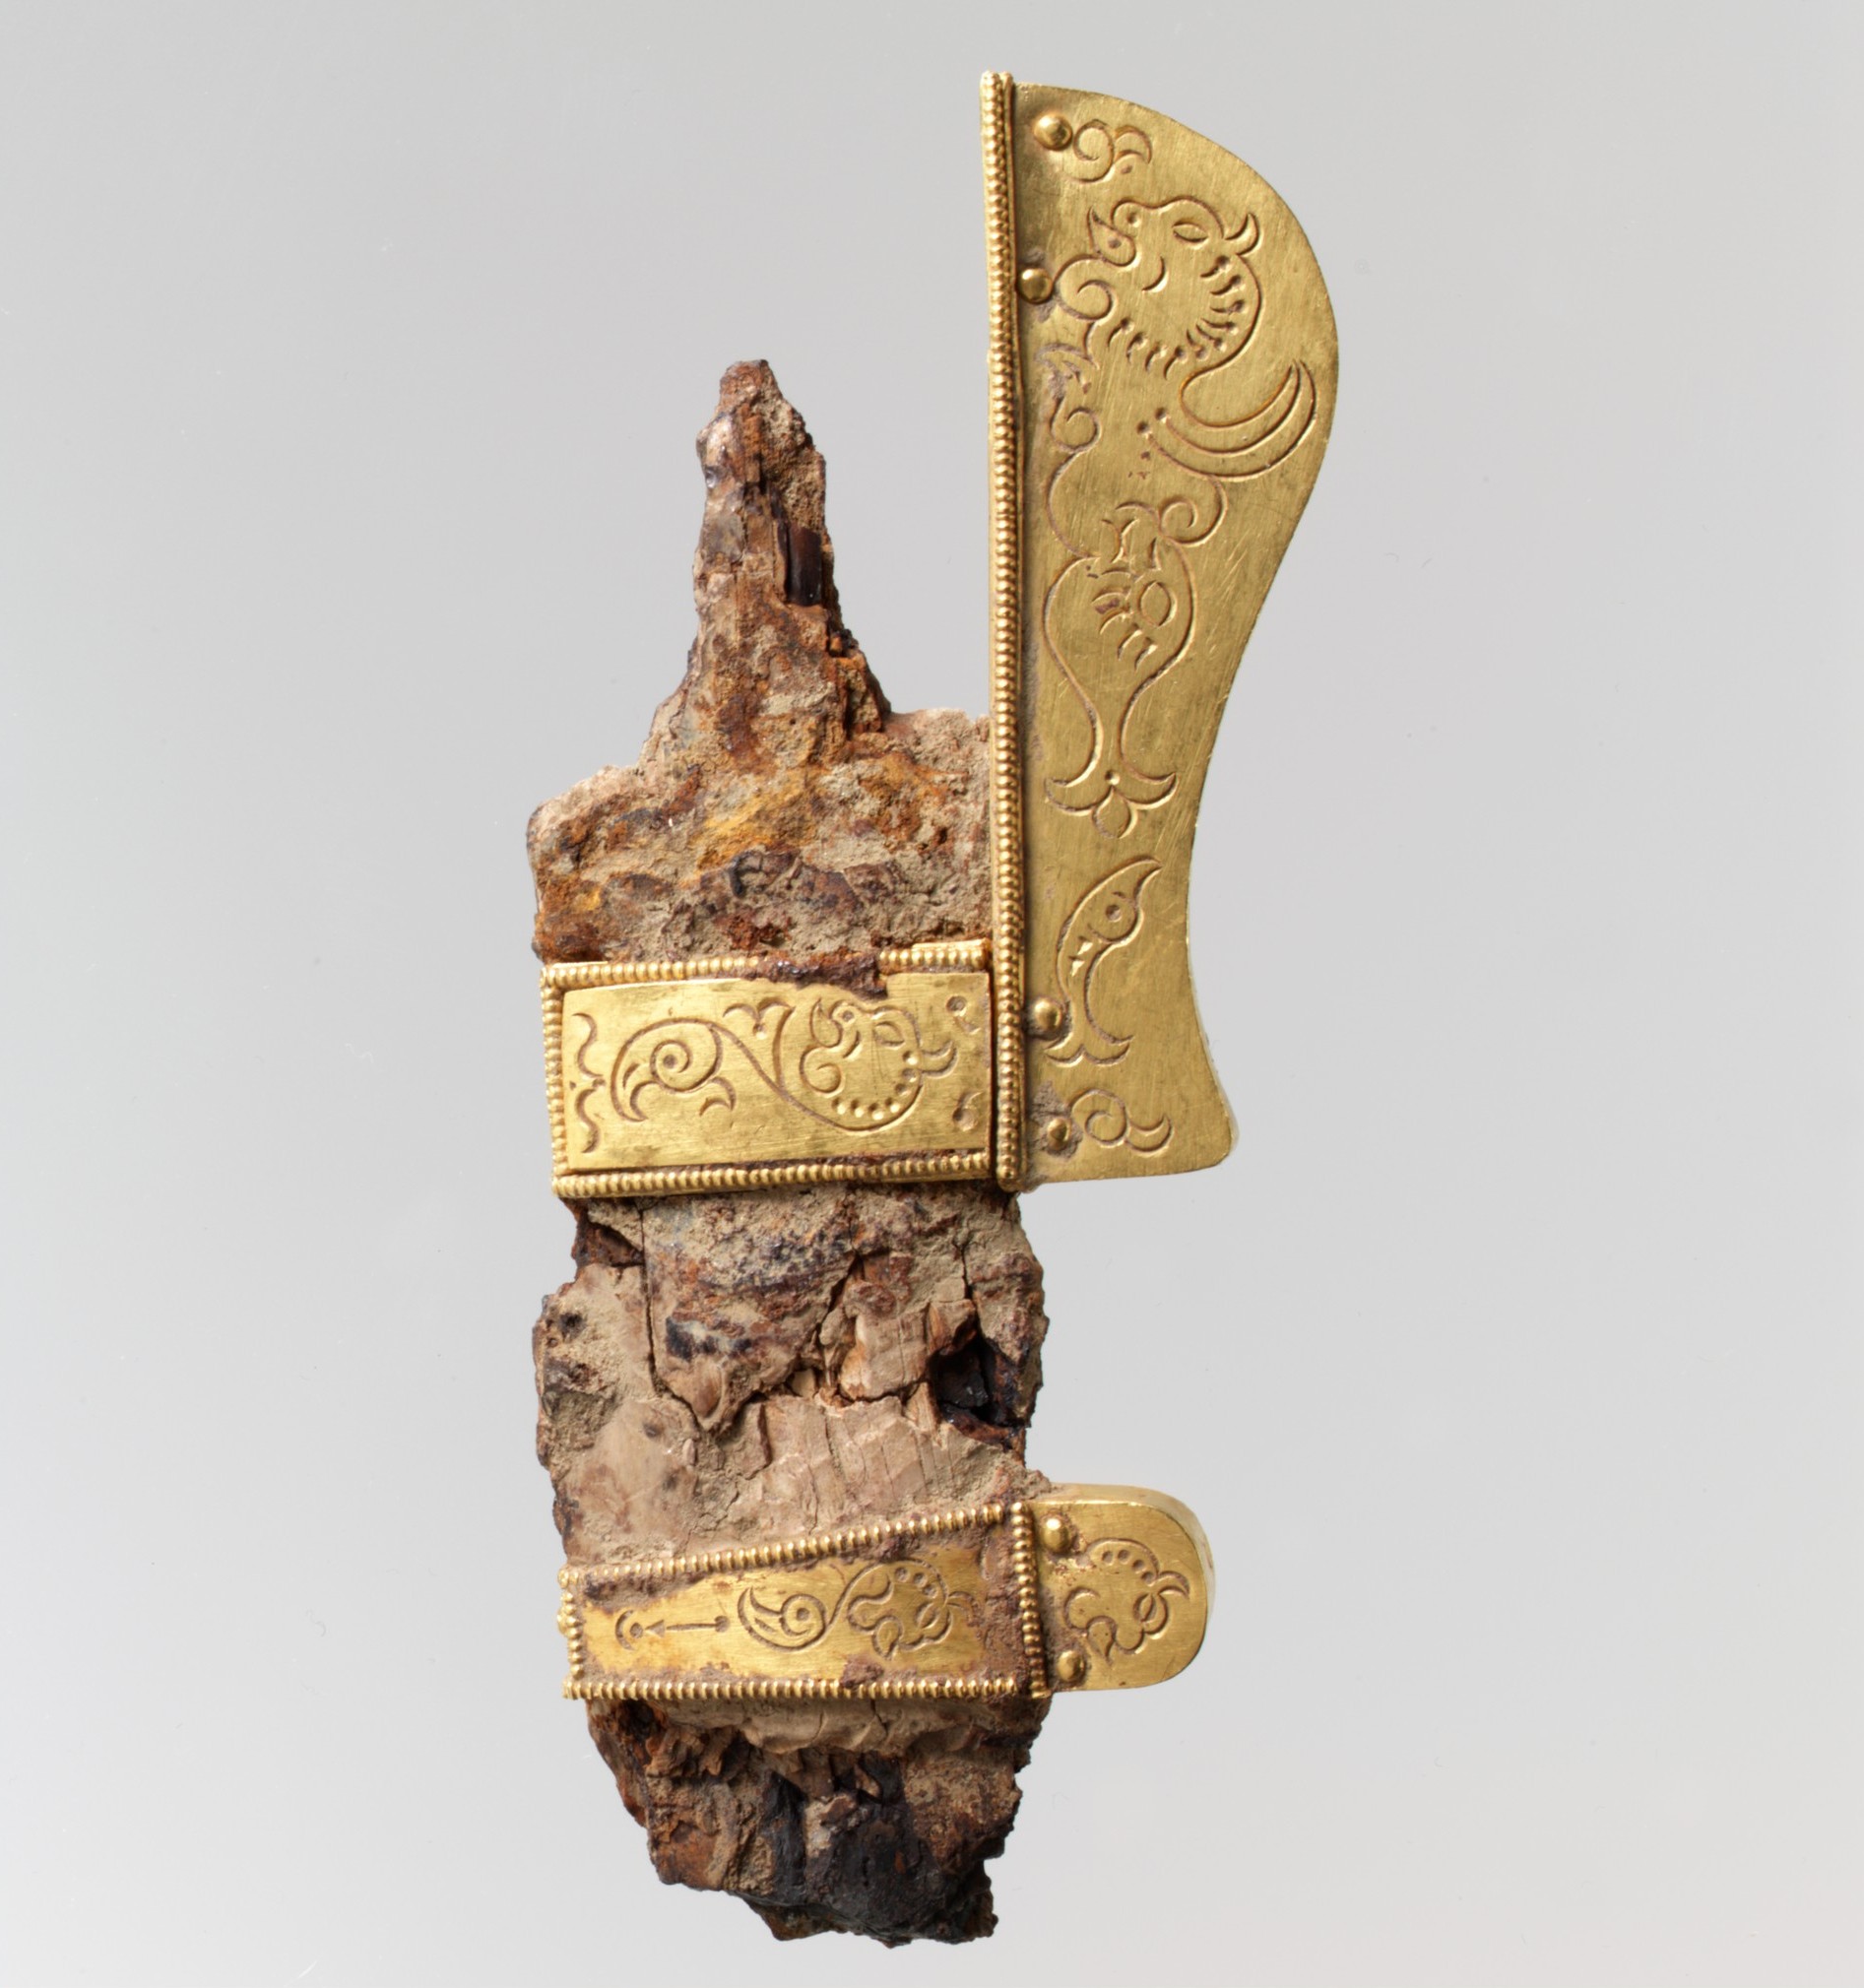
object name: sword with scabbard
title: Piece from a Luxury Dagger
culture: langobardic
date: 600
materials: gold